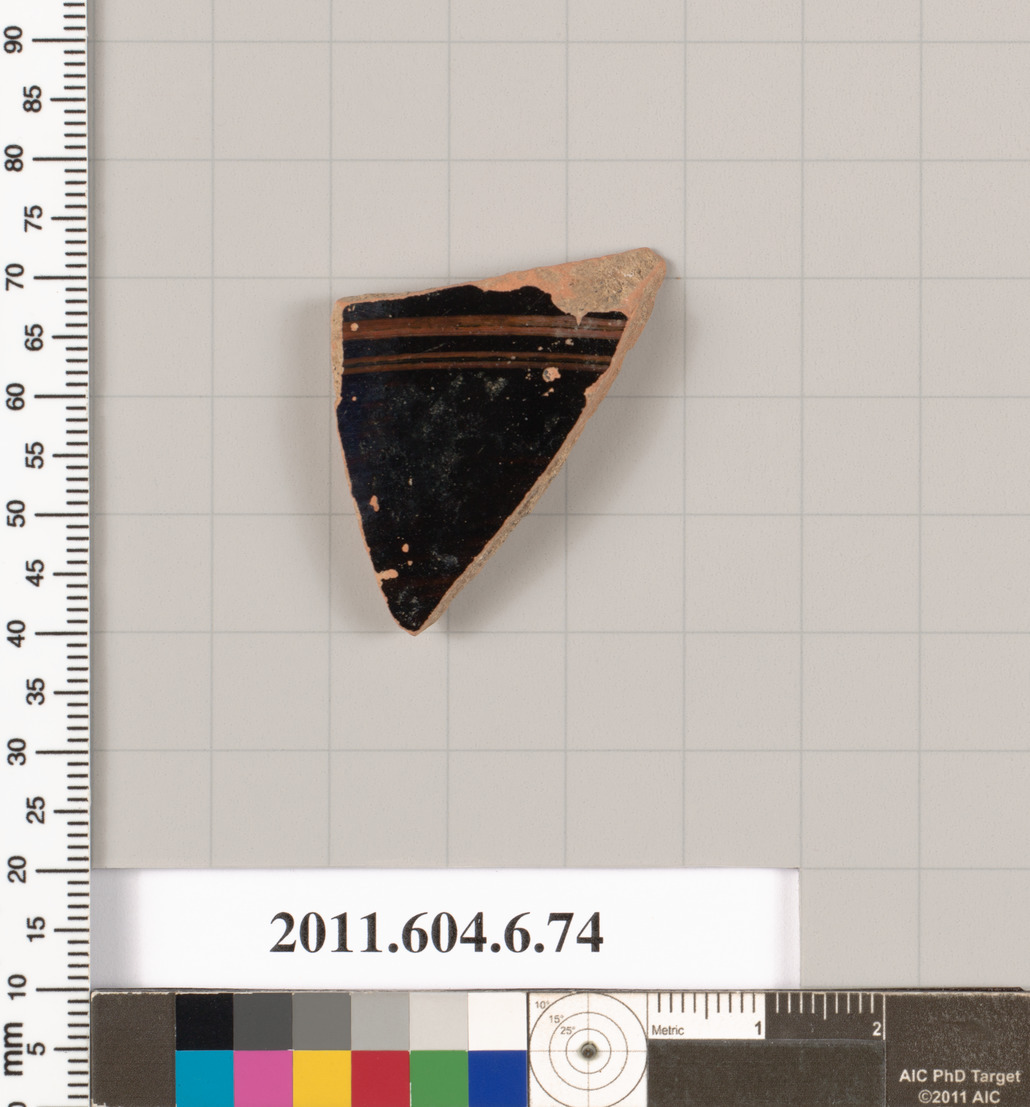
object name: undetermined closed shape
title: Terracotta fragment of a closed shape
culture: greek, attic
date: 600-401 BCE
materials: terracotta